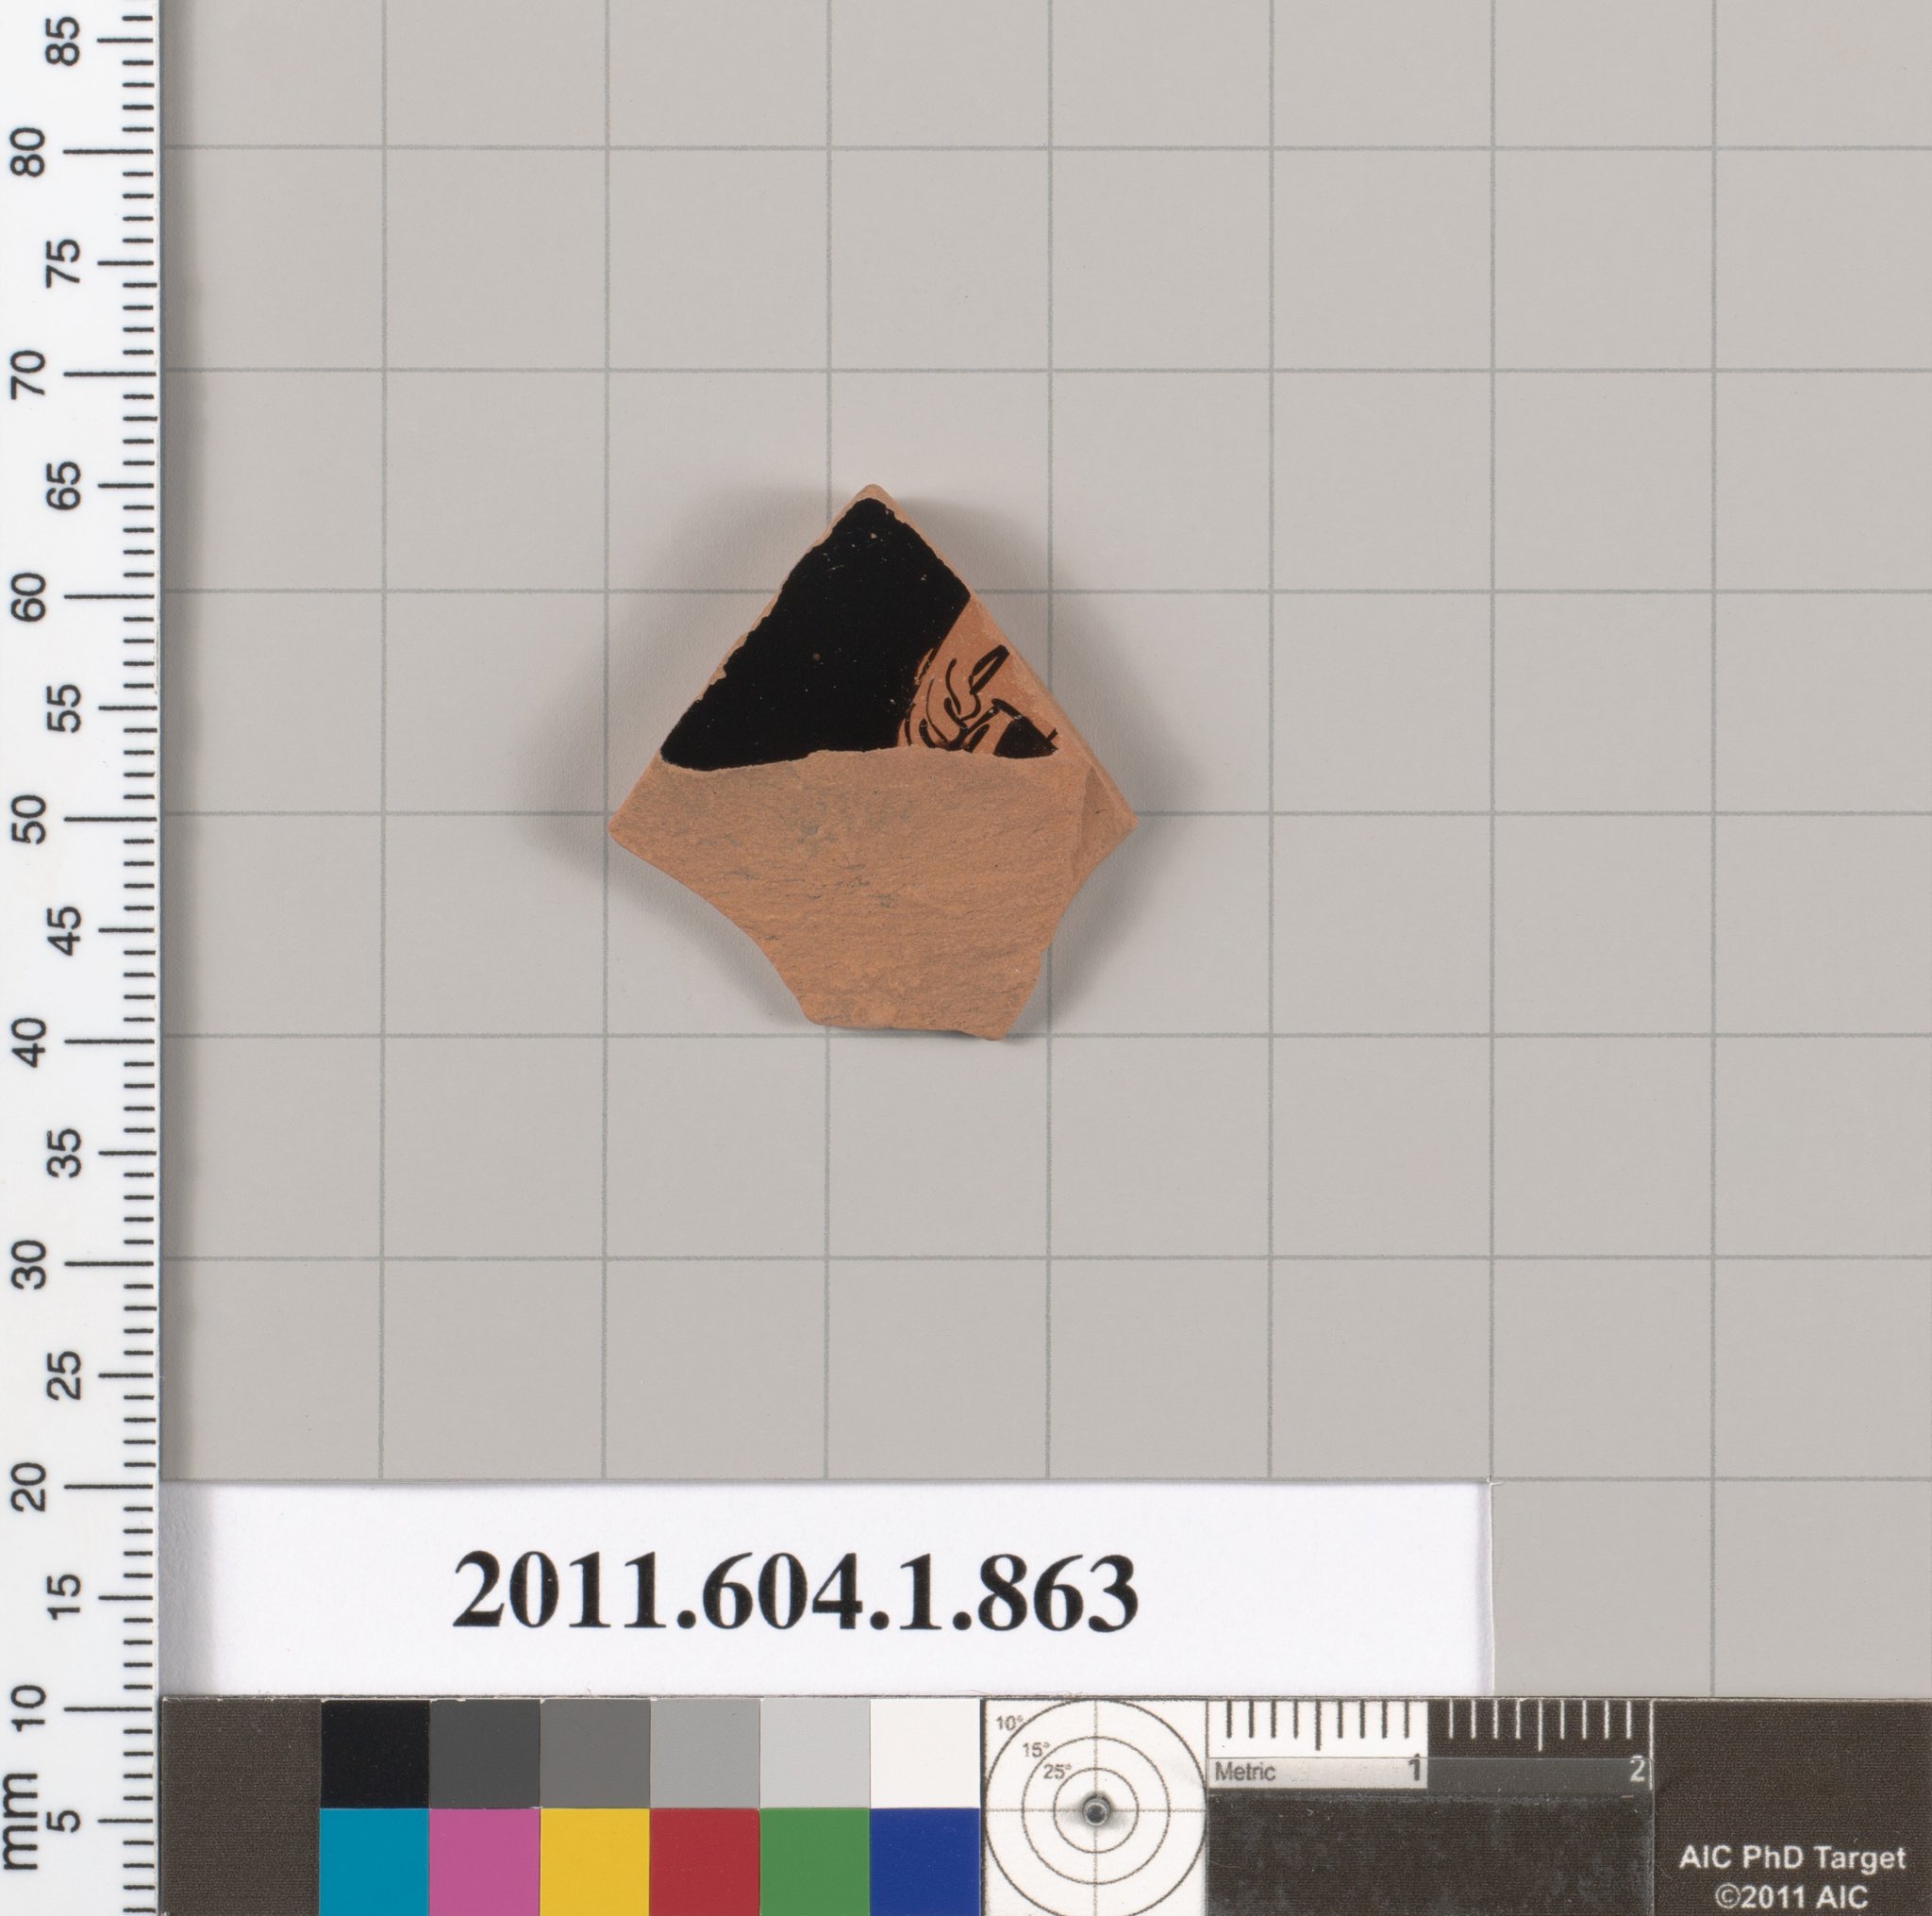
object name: kylix fragment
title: Terracotta fragment of a kylix (drinking cup)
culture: greek, attic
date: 475-451 BCE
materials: terracotta